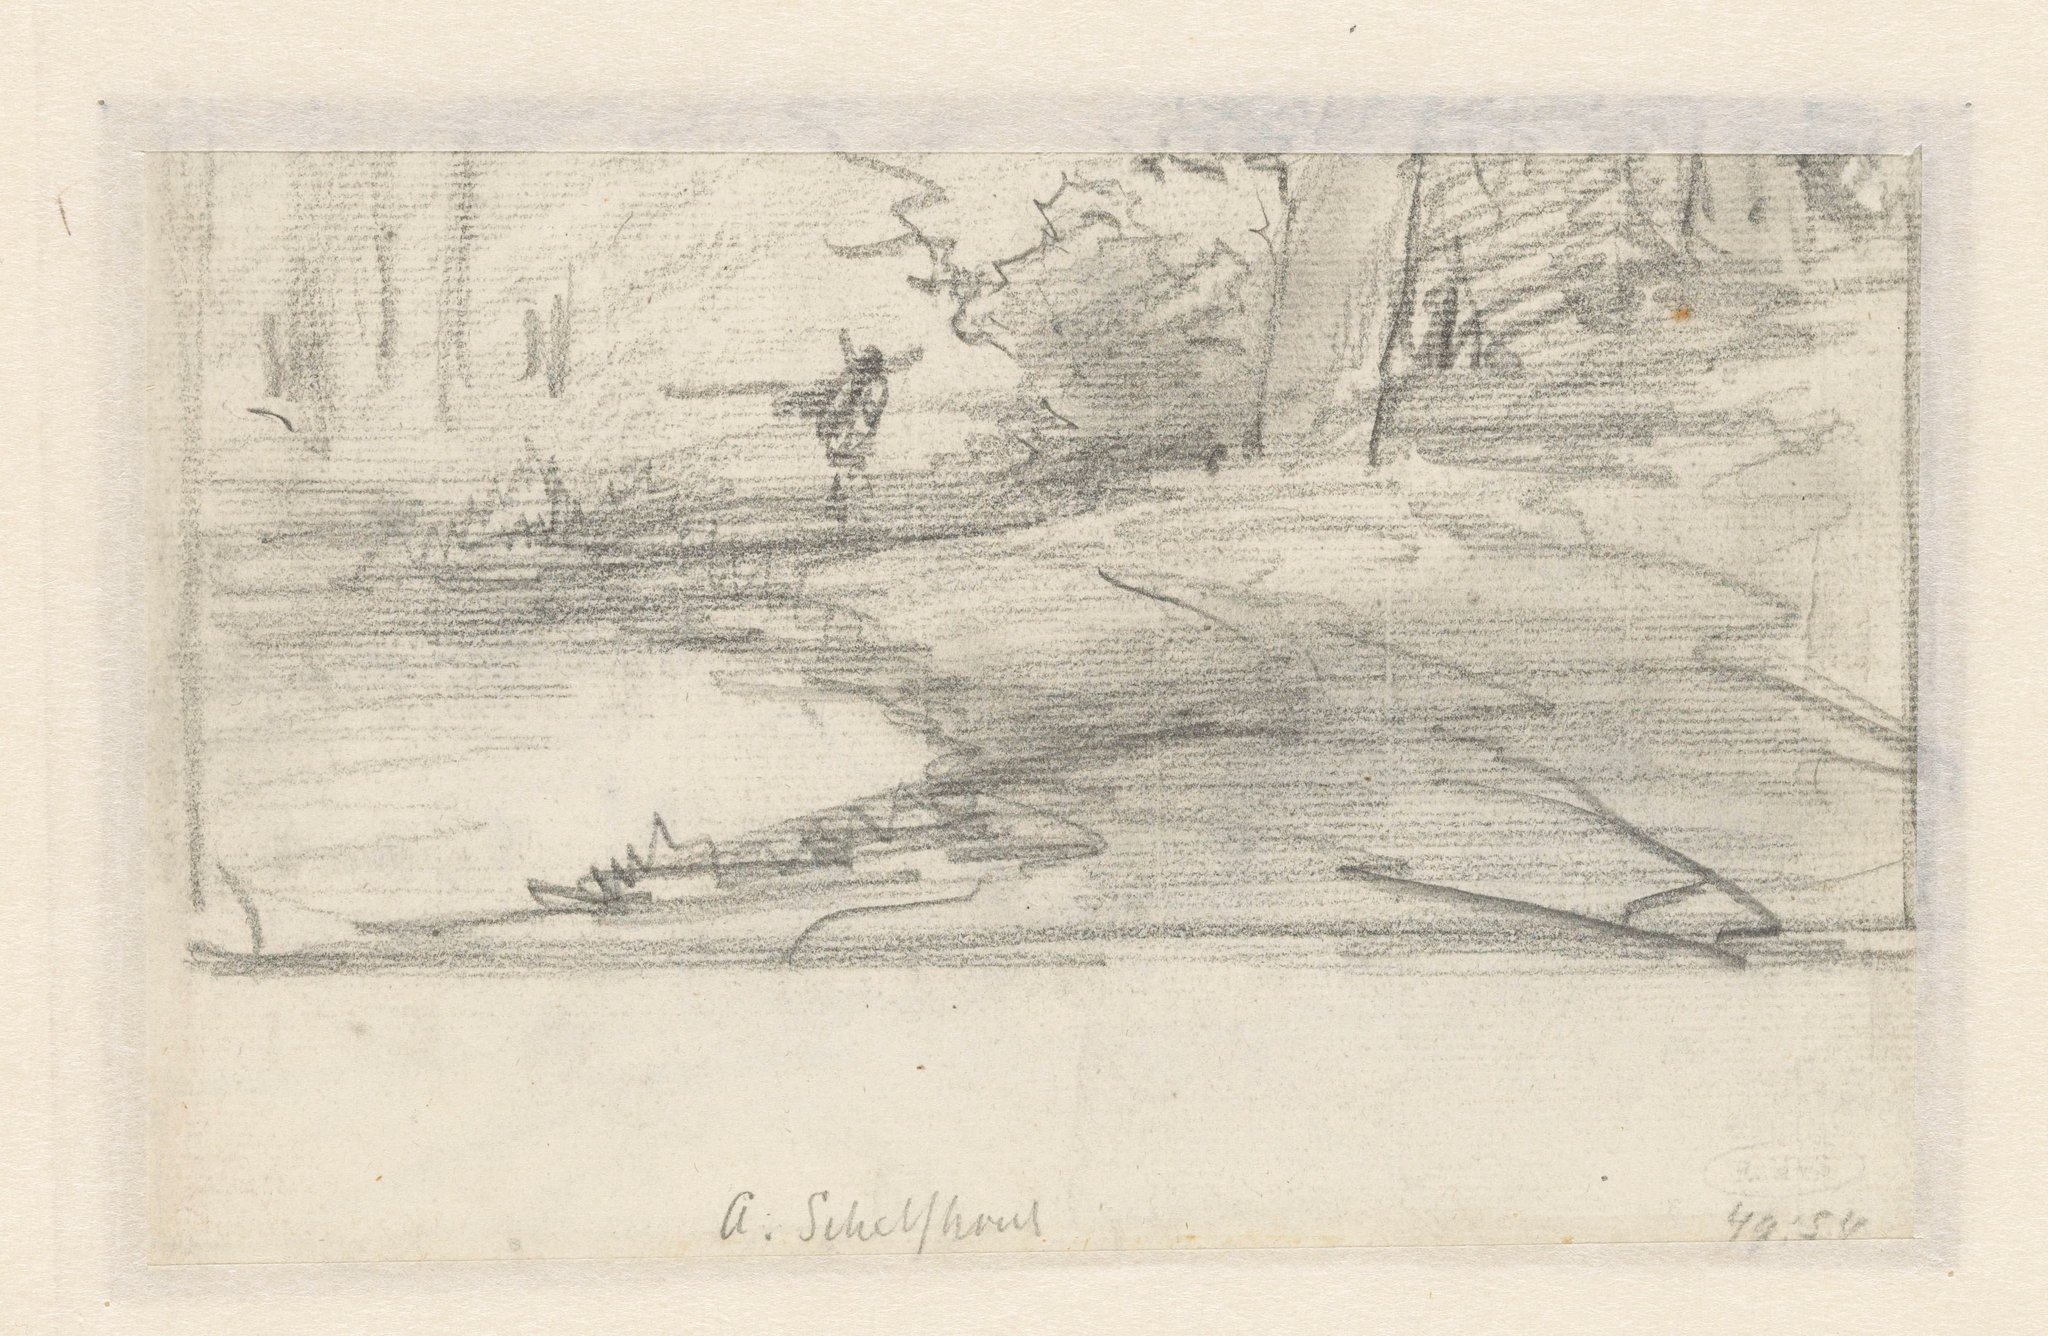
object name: drawing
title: Schets van een wandelaar op een bospad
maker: andreas schelfhout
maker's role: draughtsman, painter, print maker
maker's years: 1787-1870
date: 1797-1870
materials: paper, pencil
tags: trees